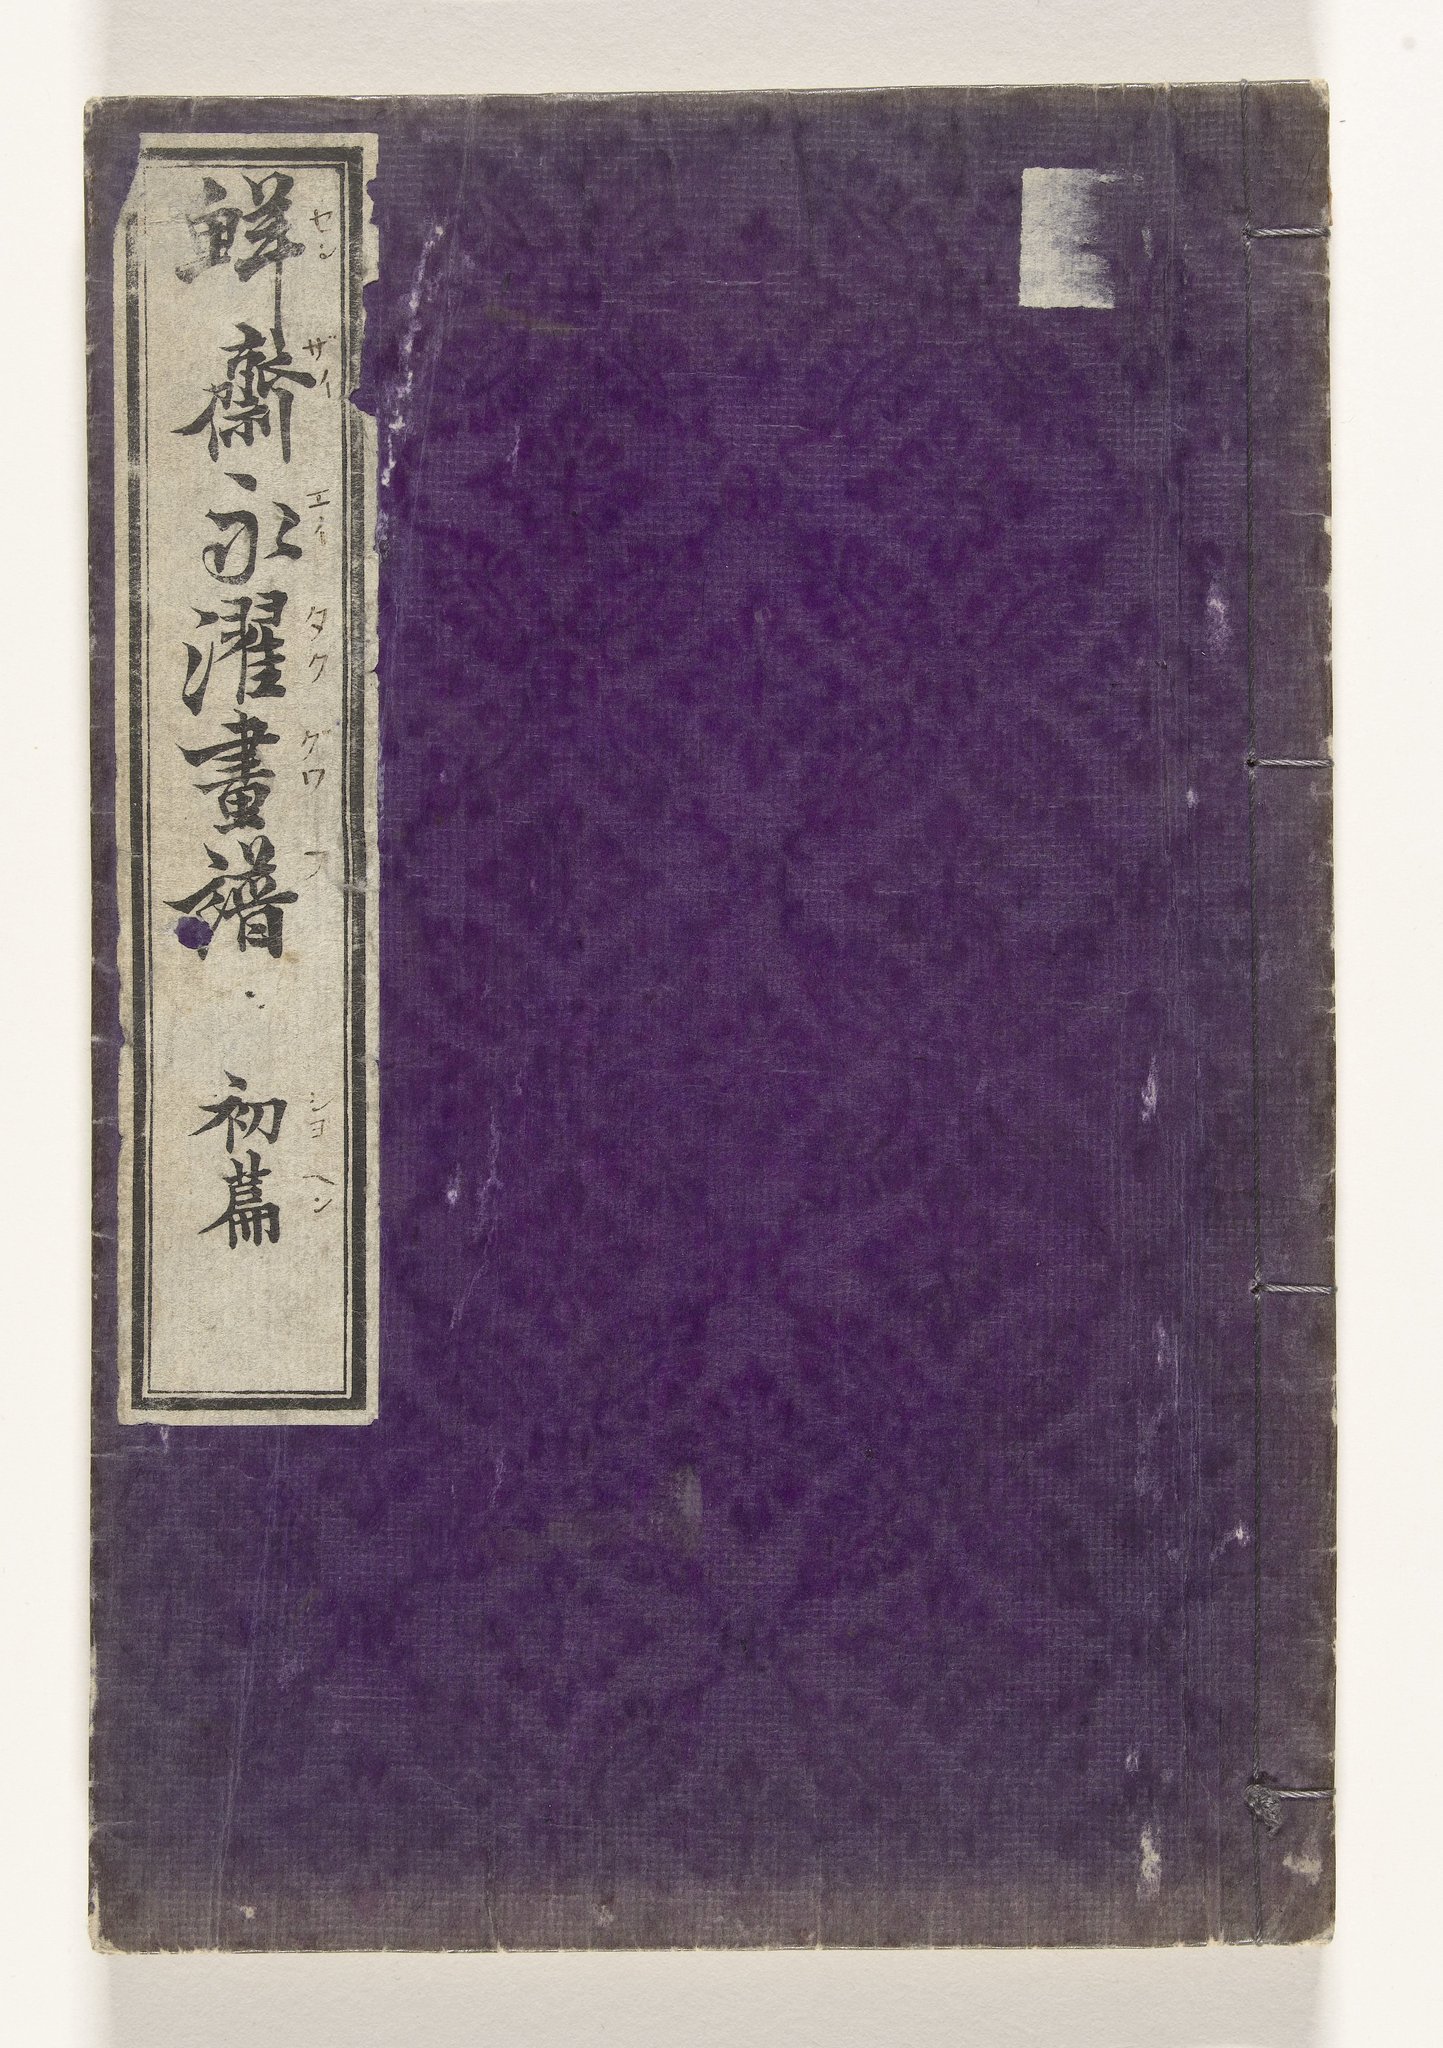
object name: book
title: Sensai Eitaku gafu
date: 1884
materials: paper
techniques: woodcut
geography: tokyo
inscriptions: date